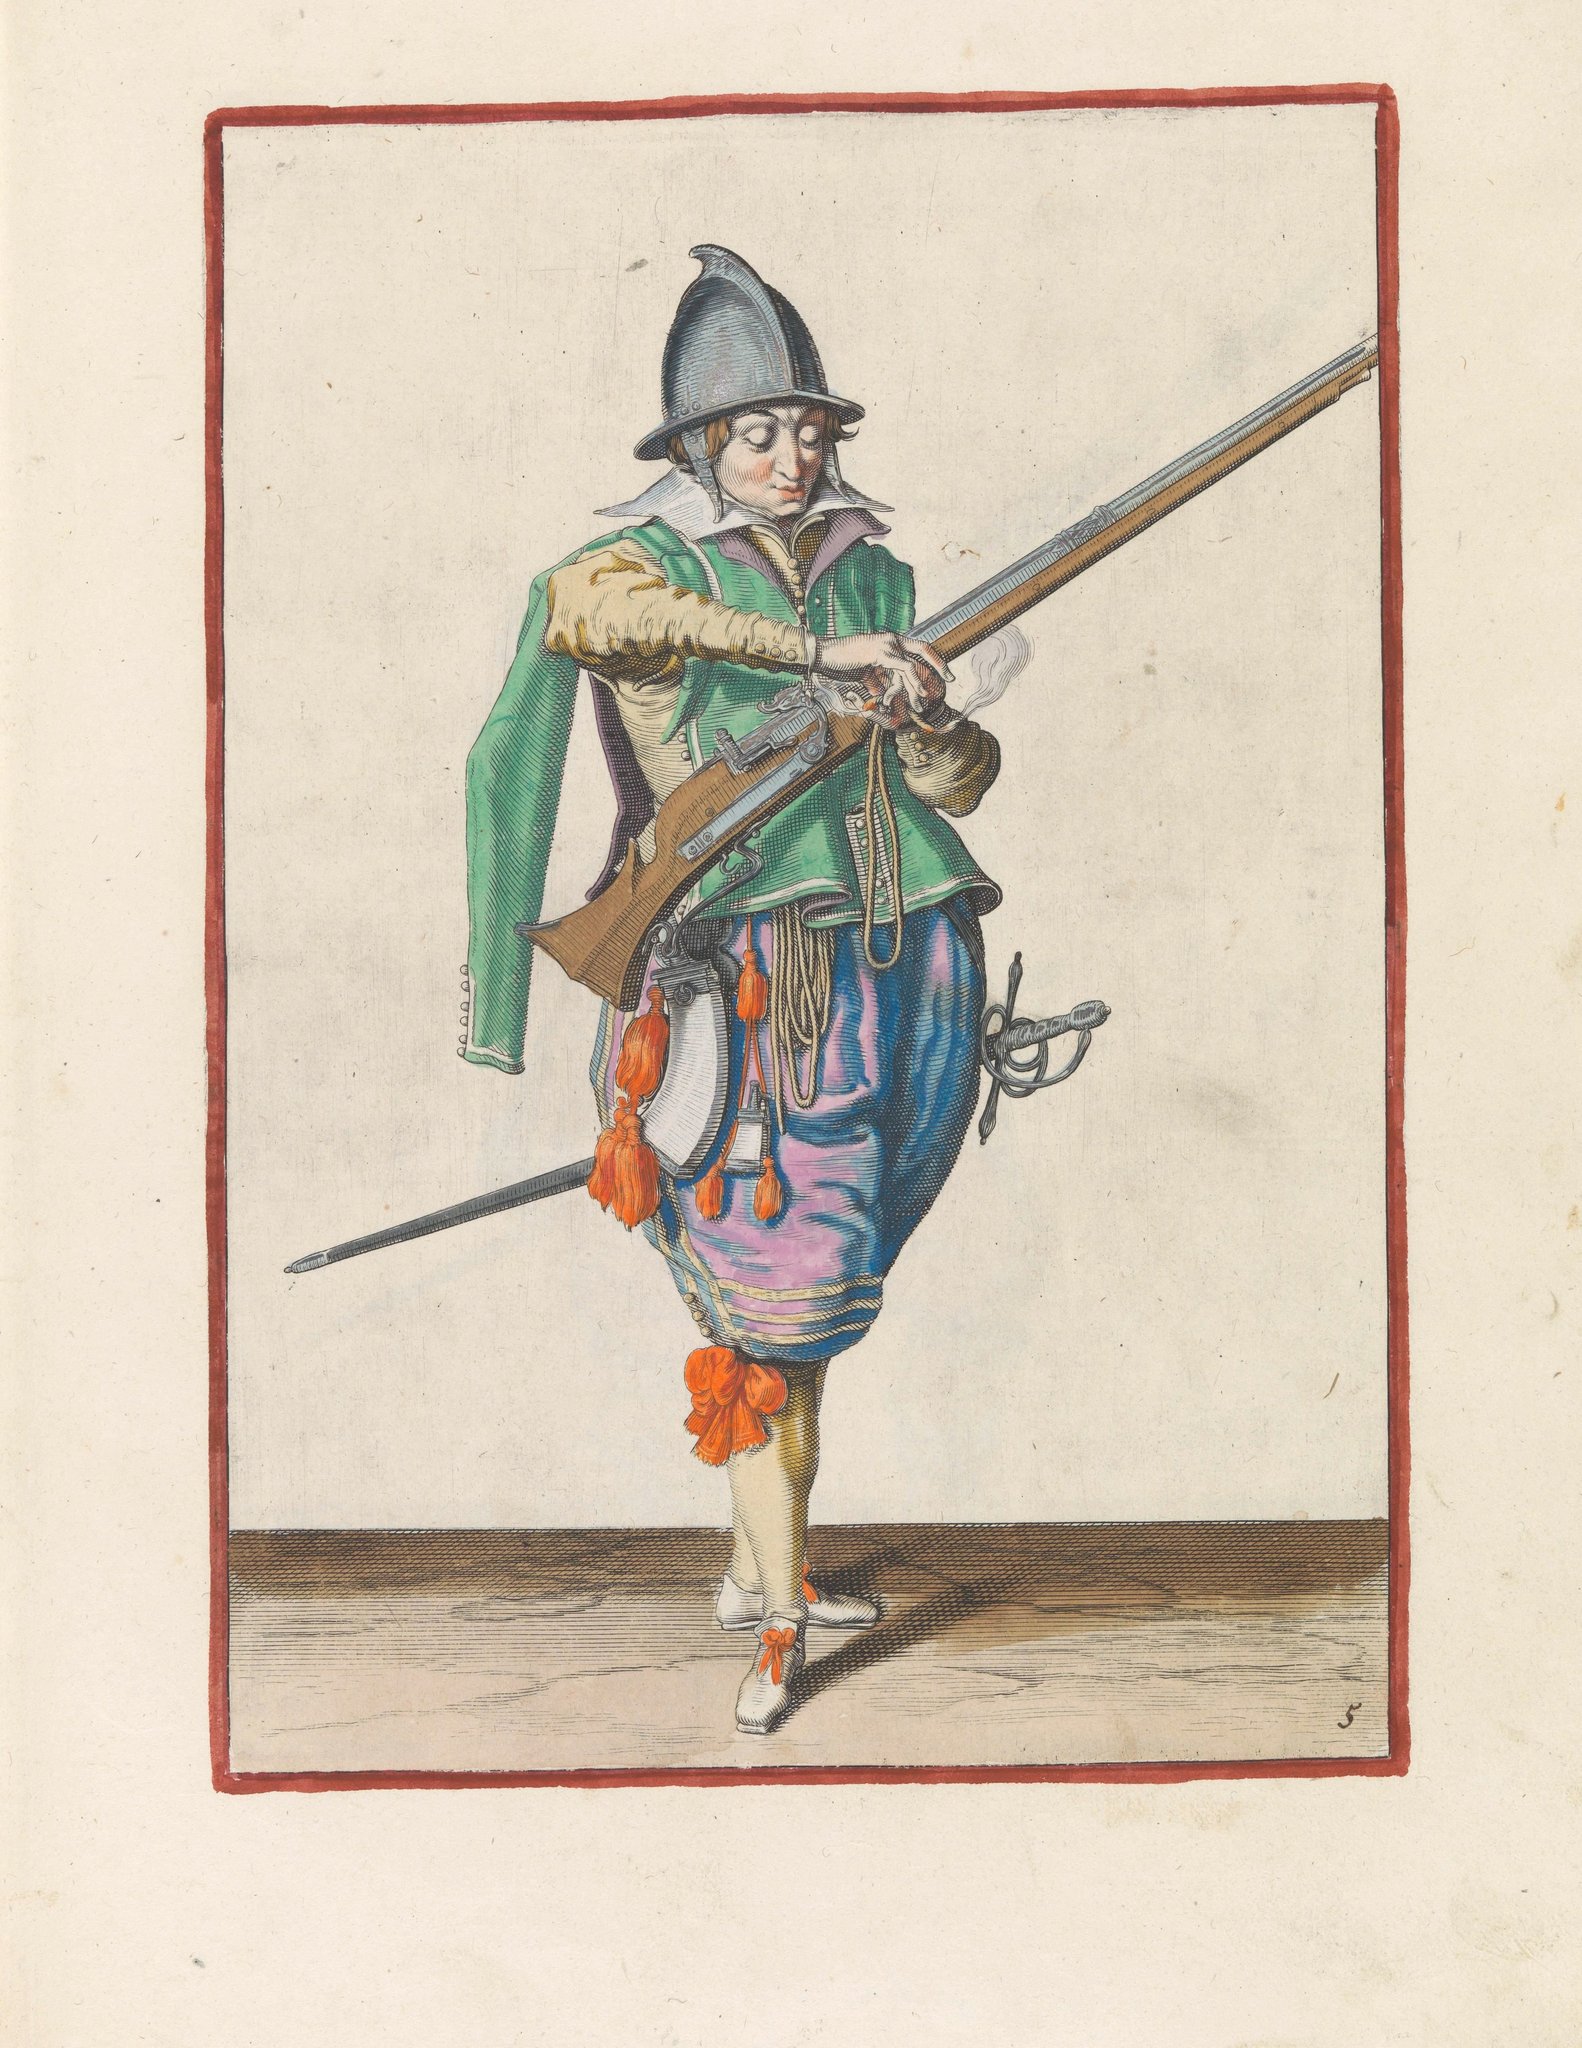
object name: print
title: Holding the Wick in the Right Hand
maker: jacques de gheyn (ii)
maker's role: painter, print maker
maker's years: 1565-1629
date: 1597-1607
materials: paper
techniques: engraving, hand coloring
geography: the hague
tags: handling of weapons ~ military training, firearms: rifle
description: The famous book Wapenhandelinghe features 117 engravings of the marksmen, musketeers and lansquenets from the army of Prince Maurice of Orange. All the actions carried out by the soldiers with their weapons are illustrated step by step, from loading to firing and thrusting. This copy is exceptionally beautifully coloured and gilded and was specially made for someone in the prince’s immediate circle.